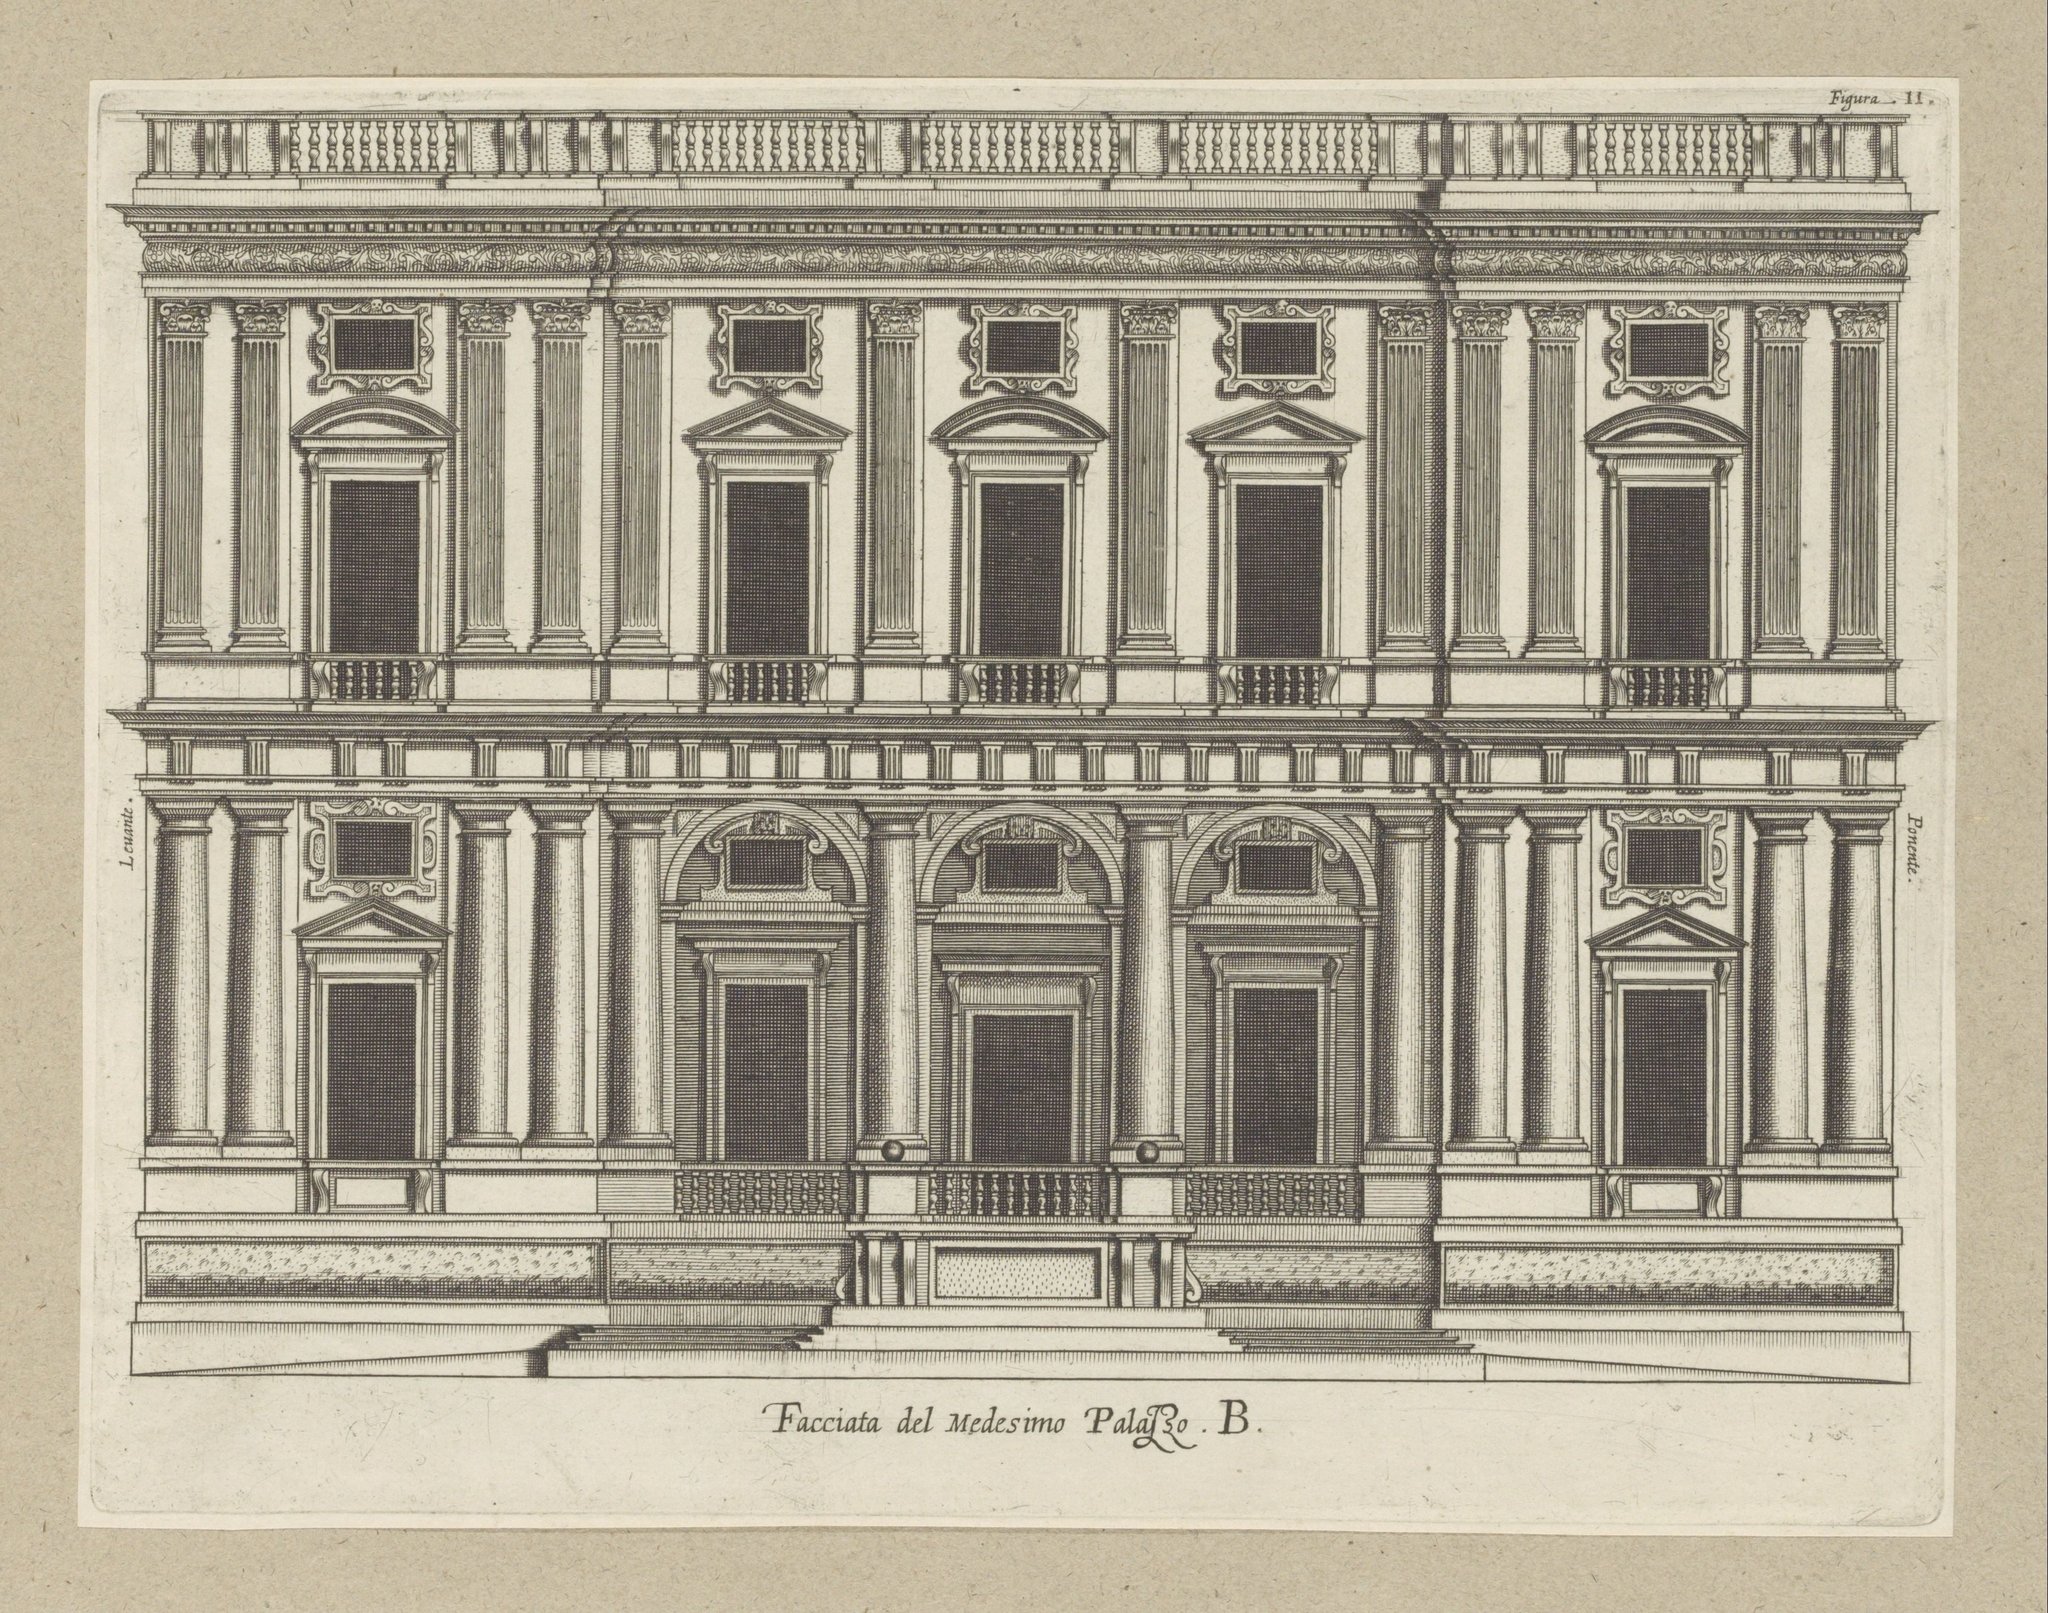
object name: print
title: Facciata del Medisimo Palazzo. B.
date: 1622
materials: paper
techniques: engraving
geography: antwerp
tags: hôtel, i.e. small palace in city, exterior ~ architectural design or model, front façade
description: Deze prent maakt deel uit van een album.